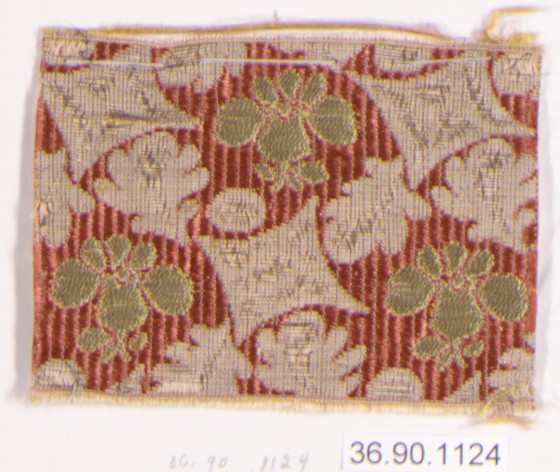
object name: sample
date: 1701-1900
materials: metal thread, silk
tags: flowers,leaves